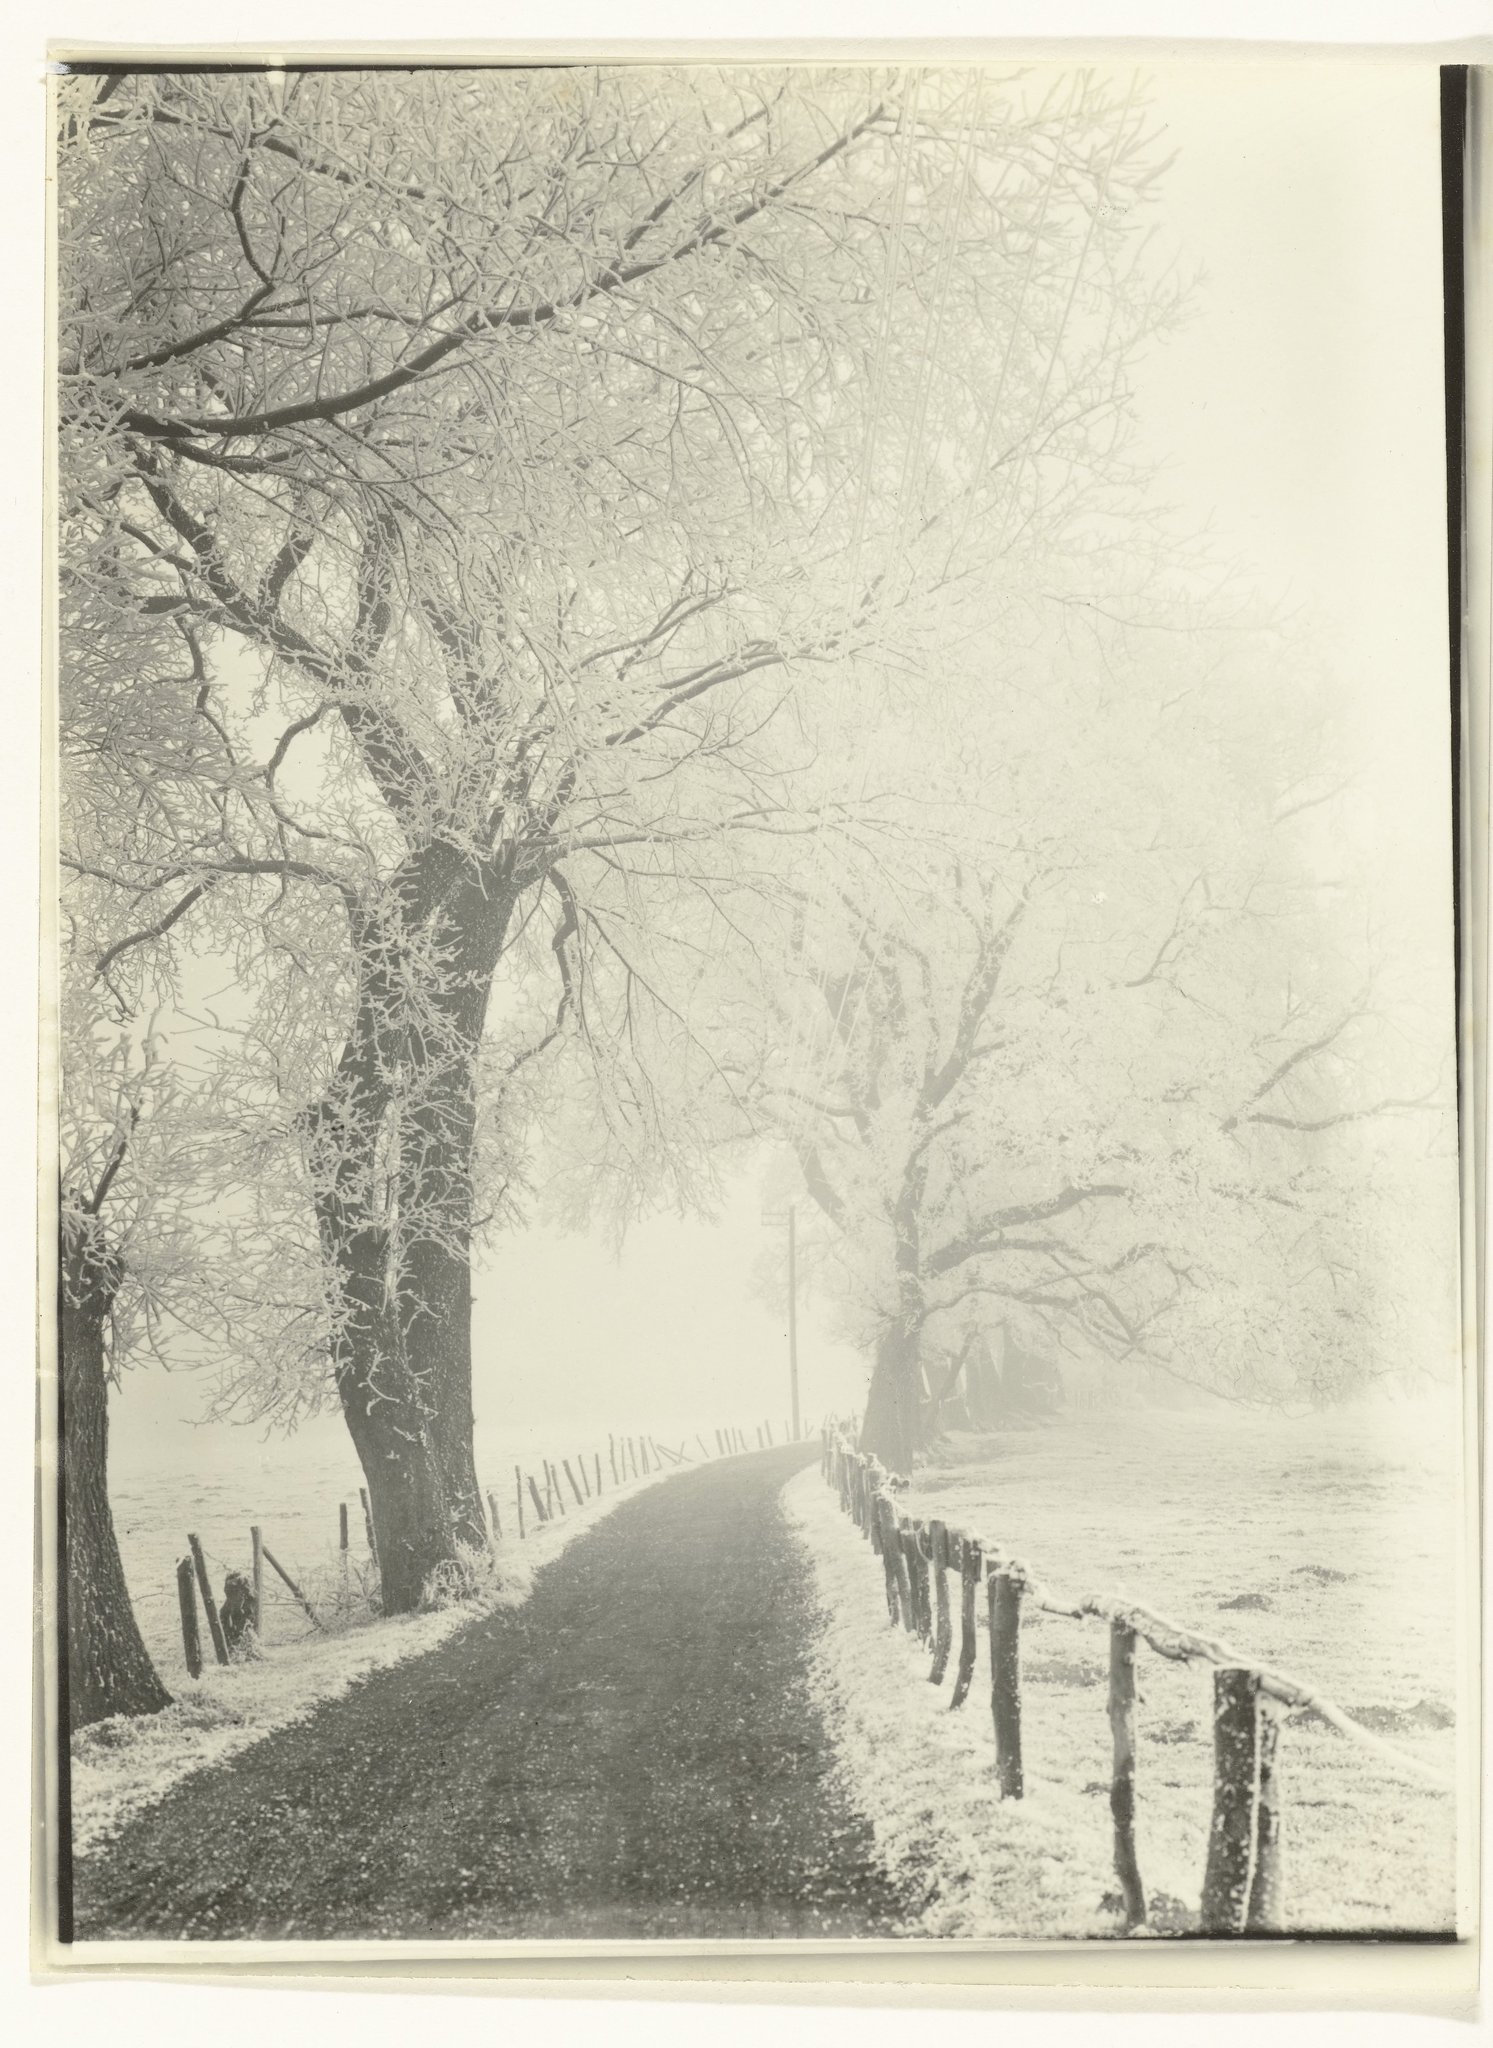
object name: photograph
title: Landweg met bomen en telegraaflijnen onder de sneeuw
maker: richard tepe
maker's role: fotograaf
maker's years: 1864-1952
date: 1900-1930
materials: cardboard, paper, photographic support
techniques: gelatin silver print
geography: netherlands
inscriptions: mark: ‘Agfa BROVIRA’